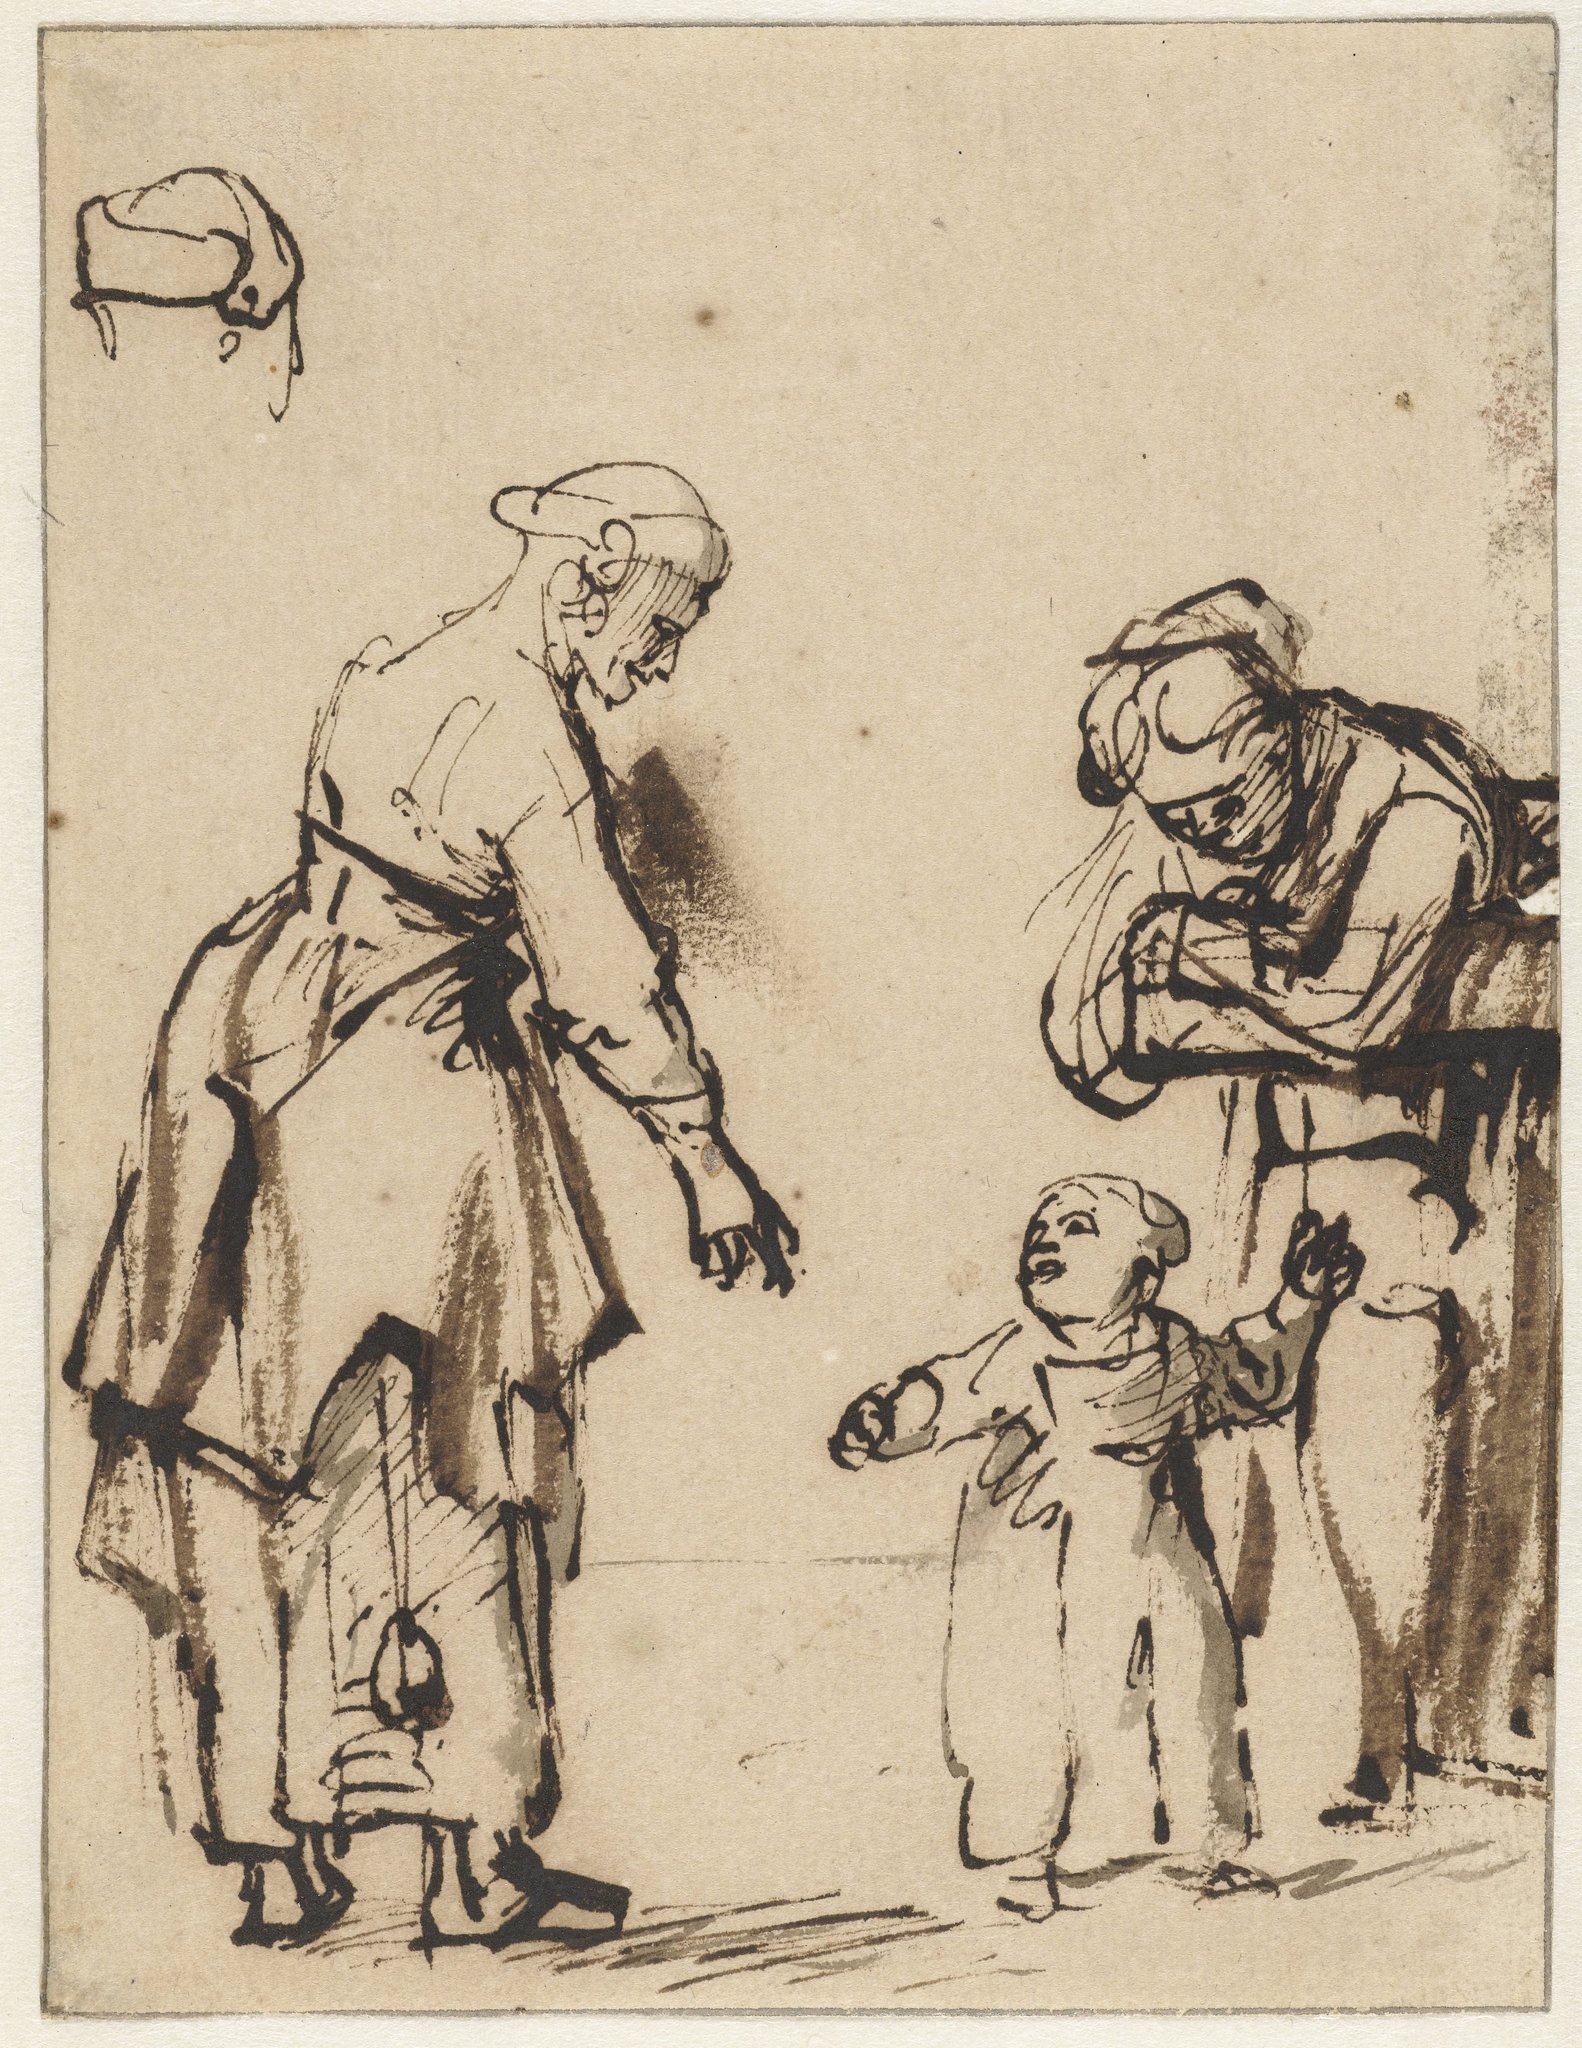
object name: drawing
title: Twee staande vrouwen met een kind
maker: carel fabritius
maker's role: draughtsman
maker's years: 1622-1654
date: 1640-1649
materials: ink, paper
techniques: brush, pen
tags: family group, especially parents with their child(ren), mother and baby or young child, learning to walk, the first steps